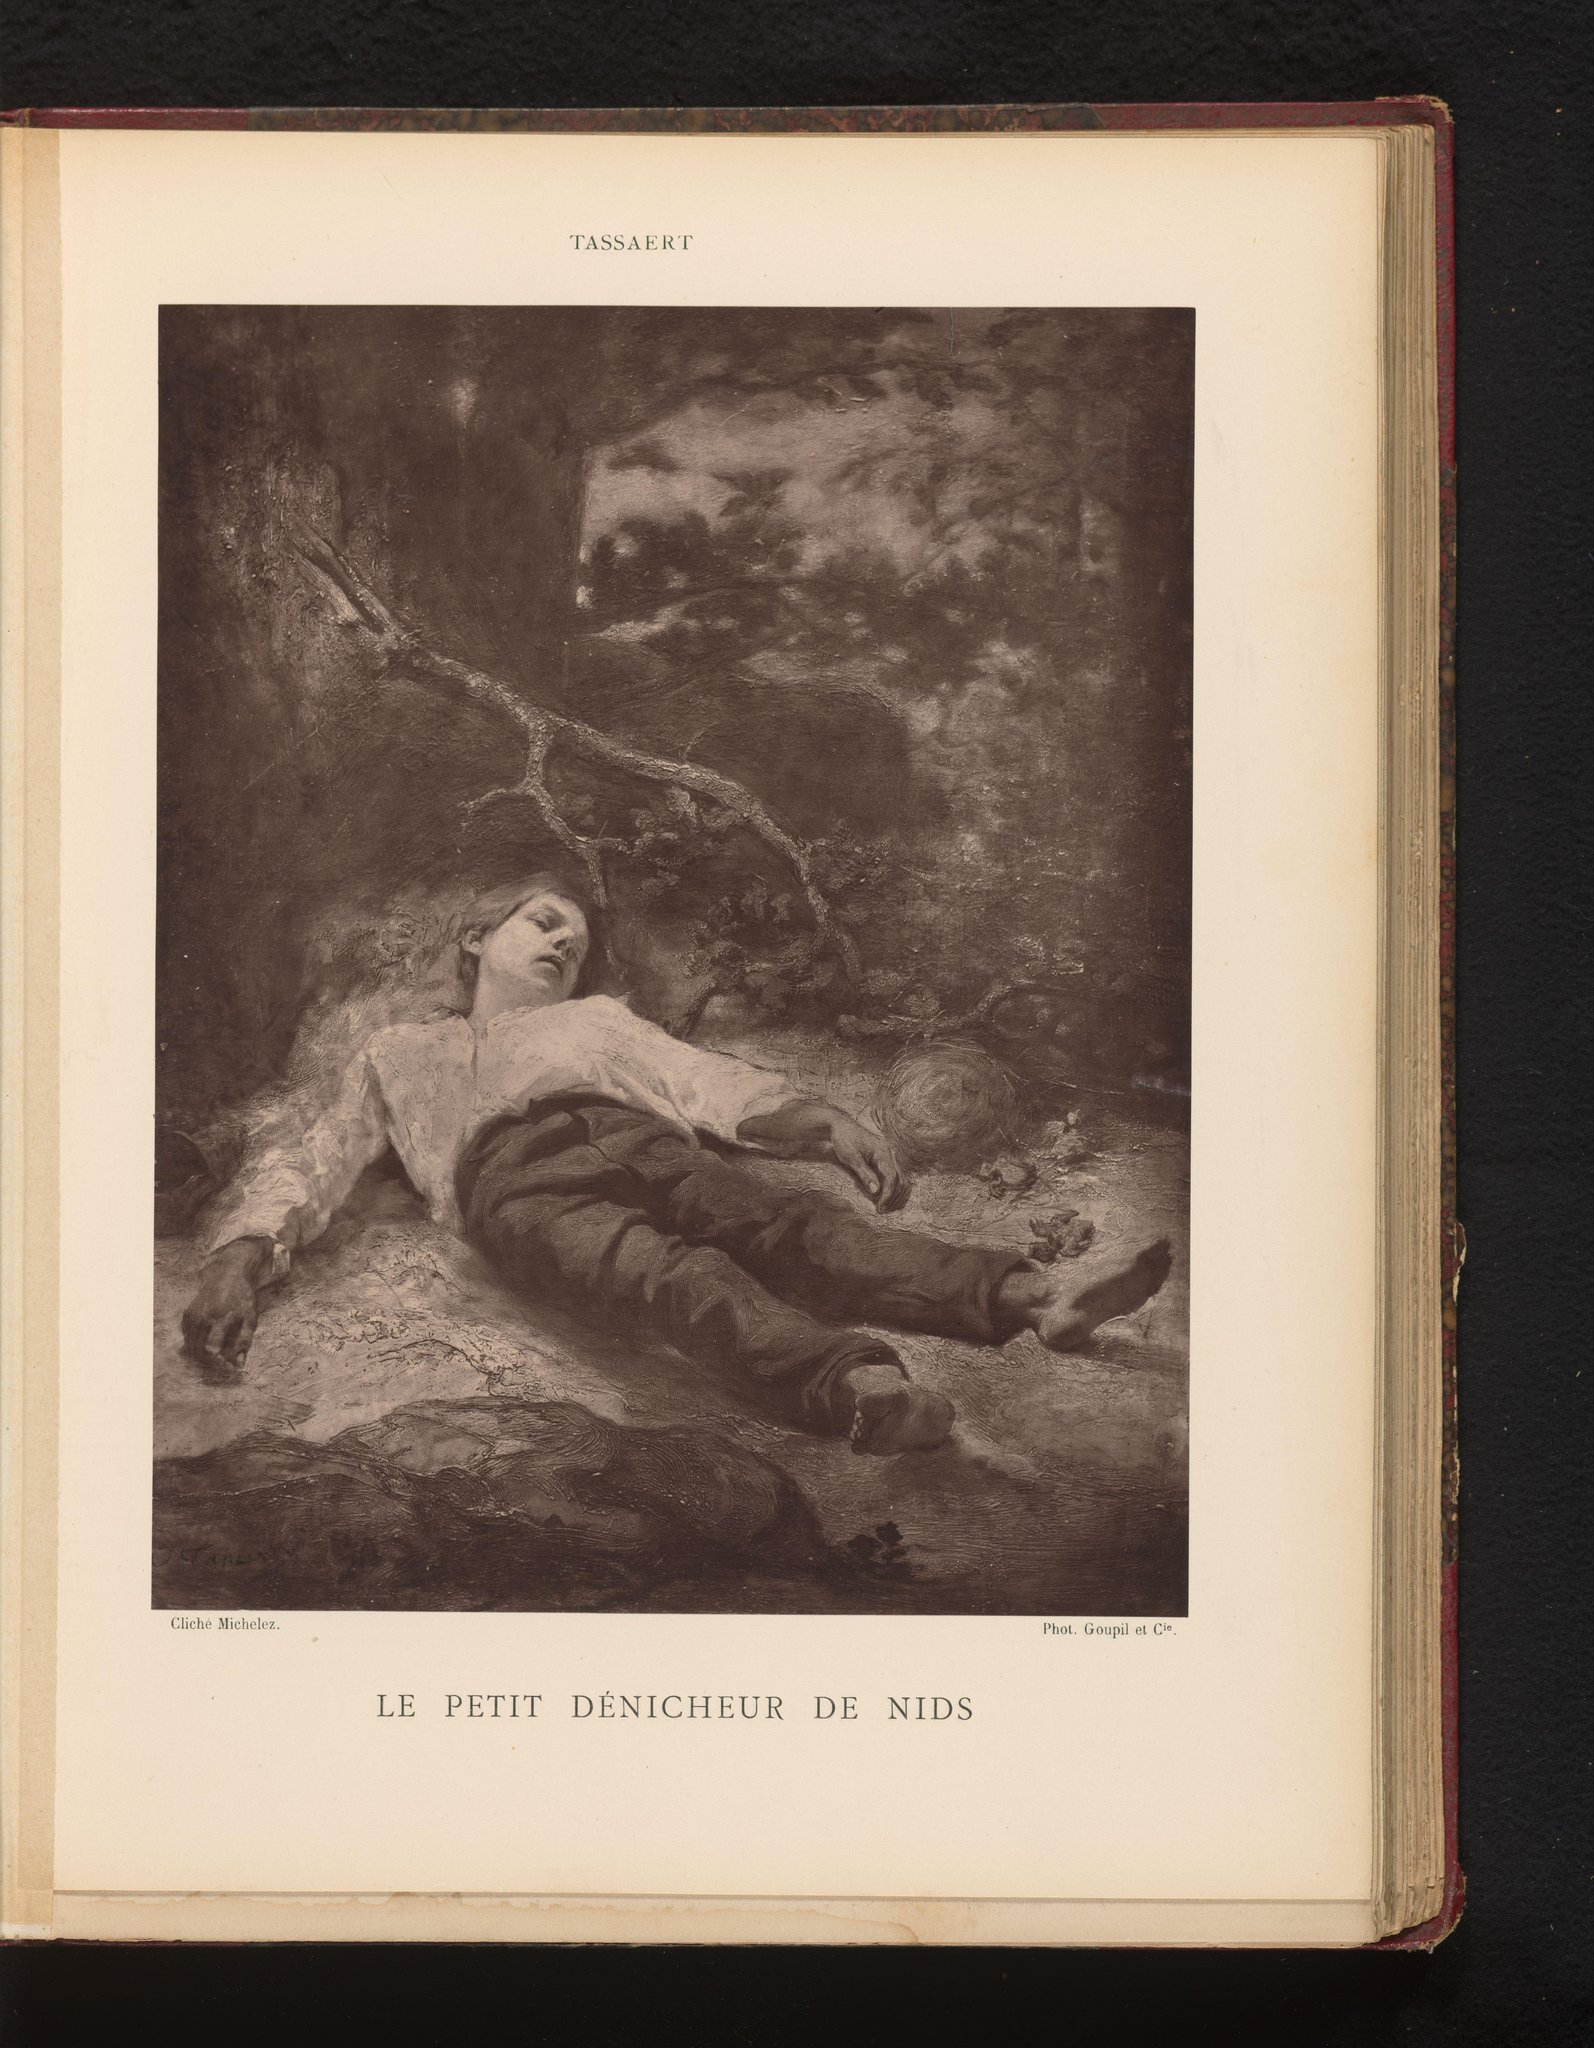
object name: photomechanical print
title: Fotoreproductie van het schilderij 'Le petit dénicheur de nids' door Nicholas Tassaert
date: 1876-1881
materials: paper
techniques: woodburytype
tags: sleeping; unconsciousness